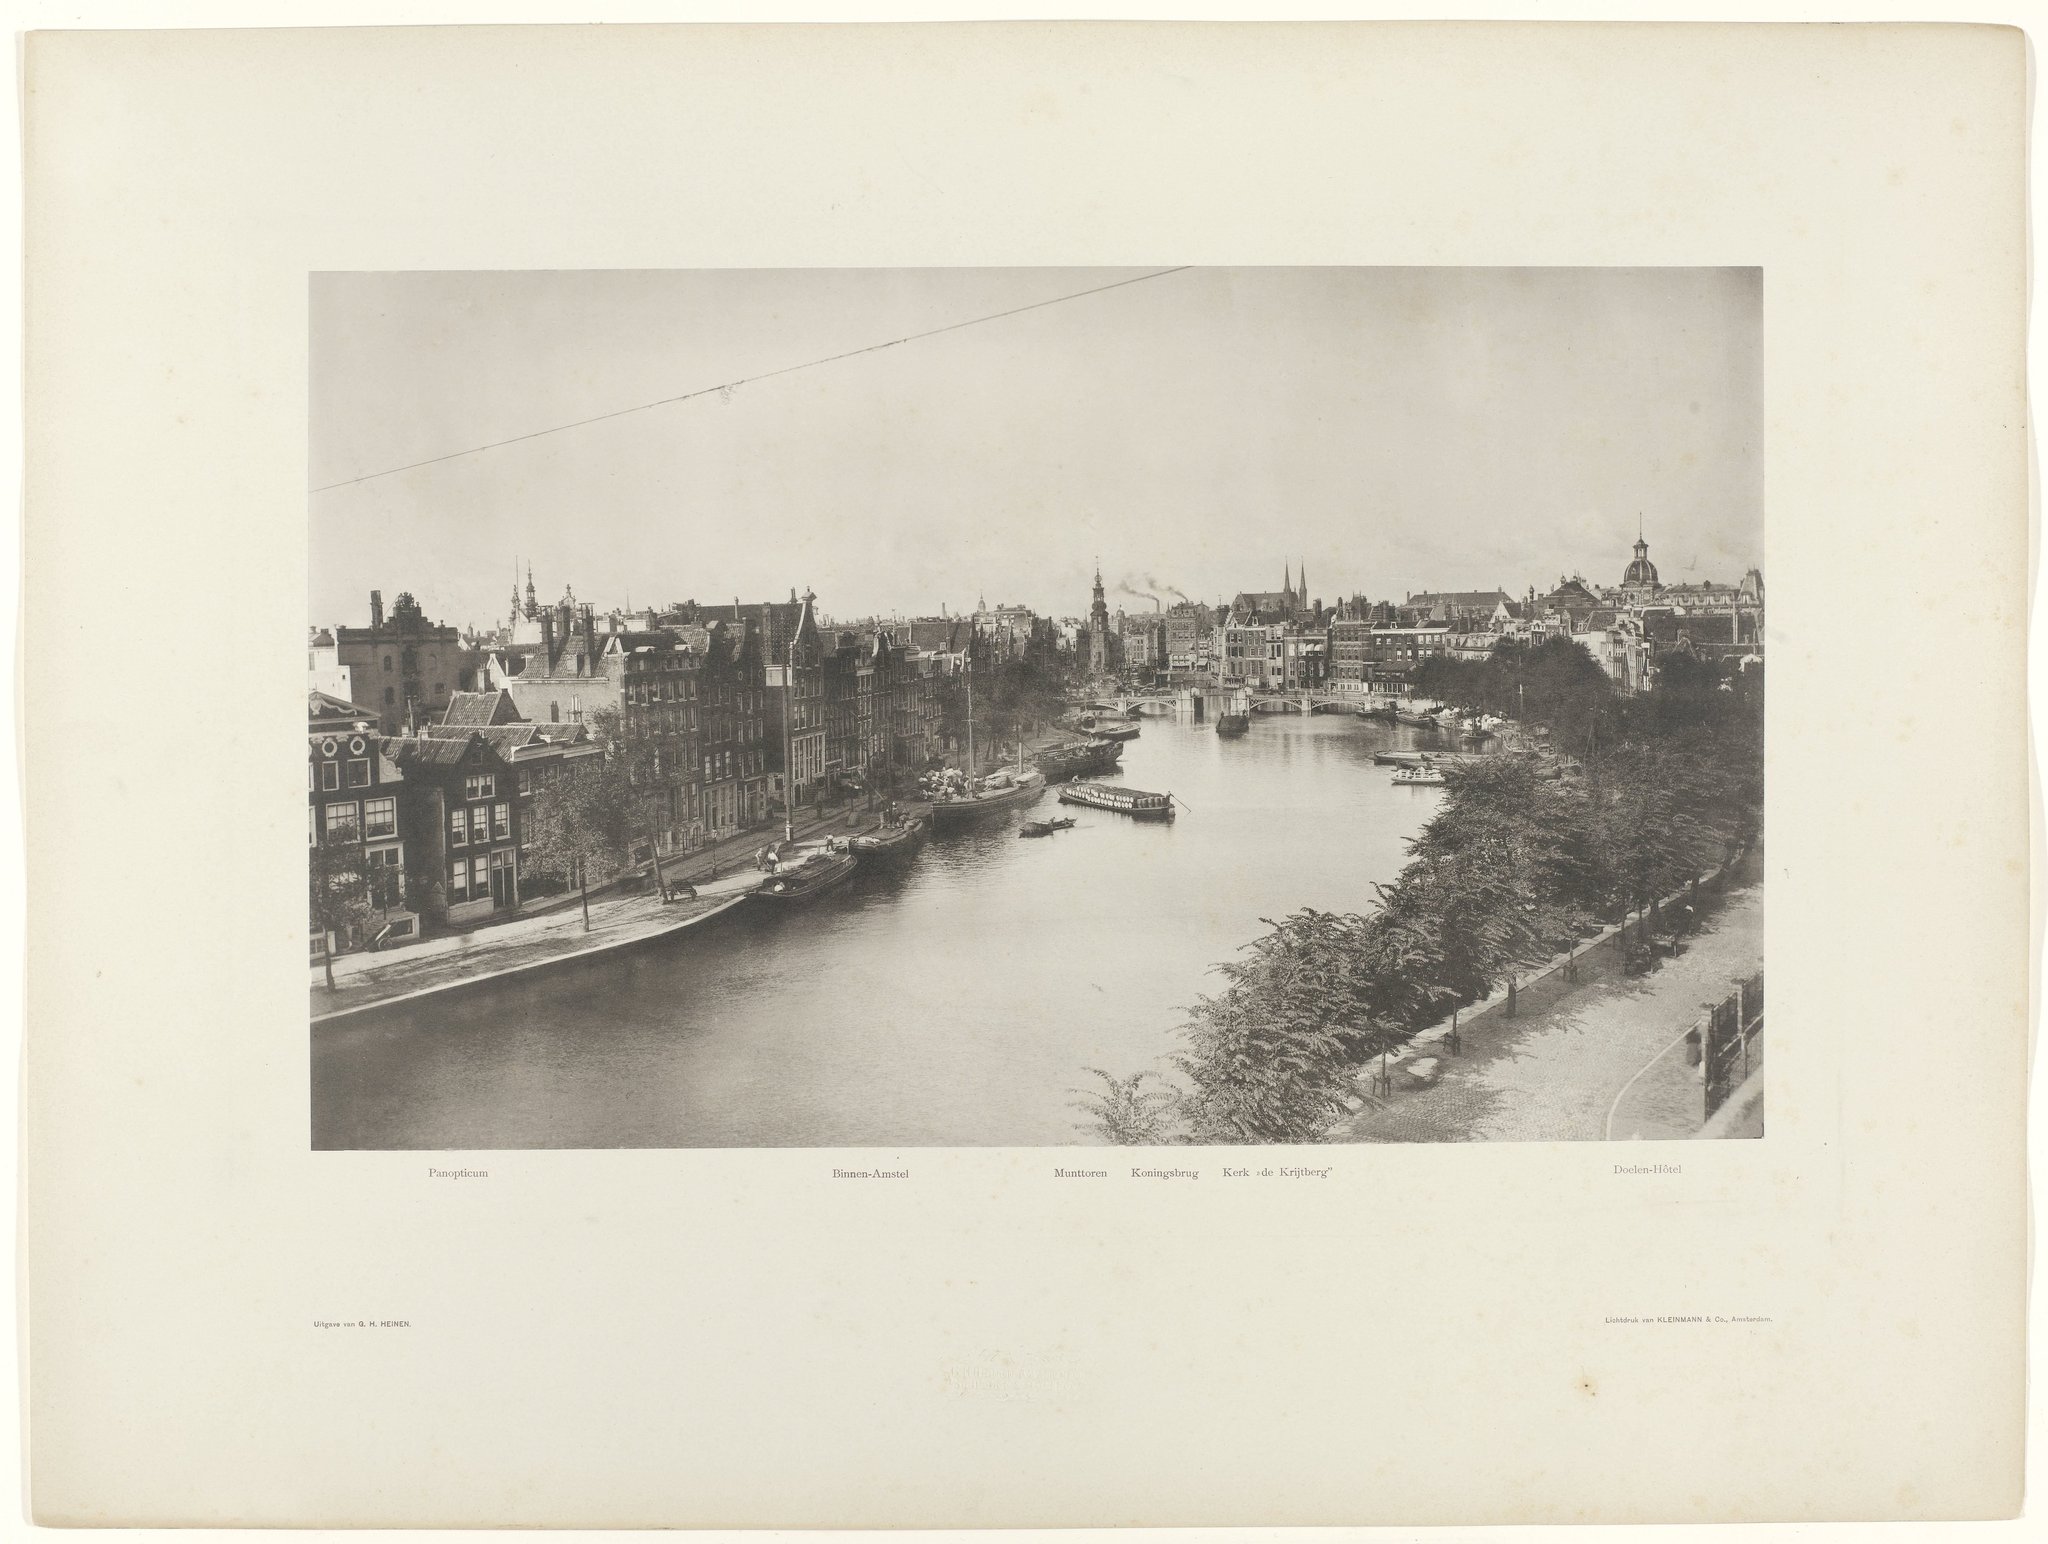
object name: photomechanical print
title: Sarphatistraat and Hoge Sluis, seen from the Paleis voor Volksvlijt; Frederiksplein and Weteringschans, seen from the Paleis voor Volksvlijt; Binnen-Amstel, seen in the direction of the Munt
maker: gerrit hendricus heinen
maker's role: painter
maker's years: 1851-1930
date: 1895-1898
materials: paper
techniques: photograph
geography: amsterdam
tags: city-view in general; 'veduta', canals, waters (in city)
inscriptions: check stamp: ‘G.H. Heinen Amsterdam/ Schilder & Fotograaf’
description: At the dawn of the 20th century, Amsterdam’s rapidly changing face served as the setting for photographer and decorative painter Heinen. With camera at hand, he climbed tall buildings, such as the Paleis voor Volksvlijt (Palace for Art and Industry), which burned down in 1929, and the Rijksmuseum, to take his panoramas.